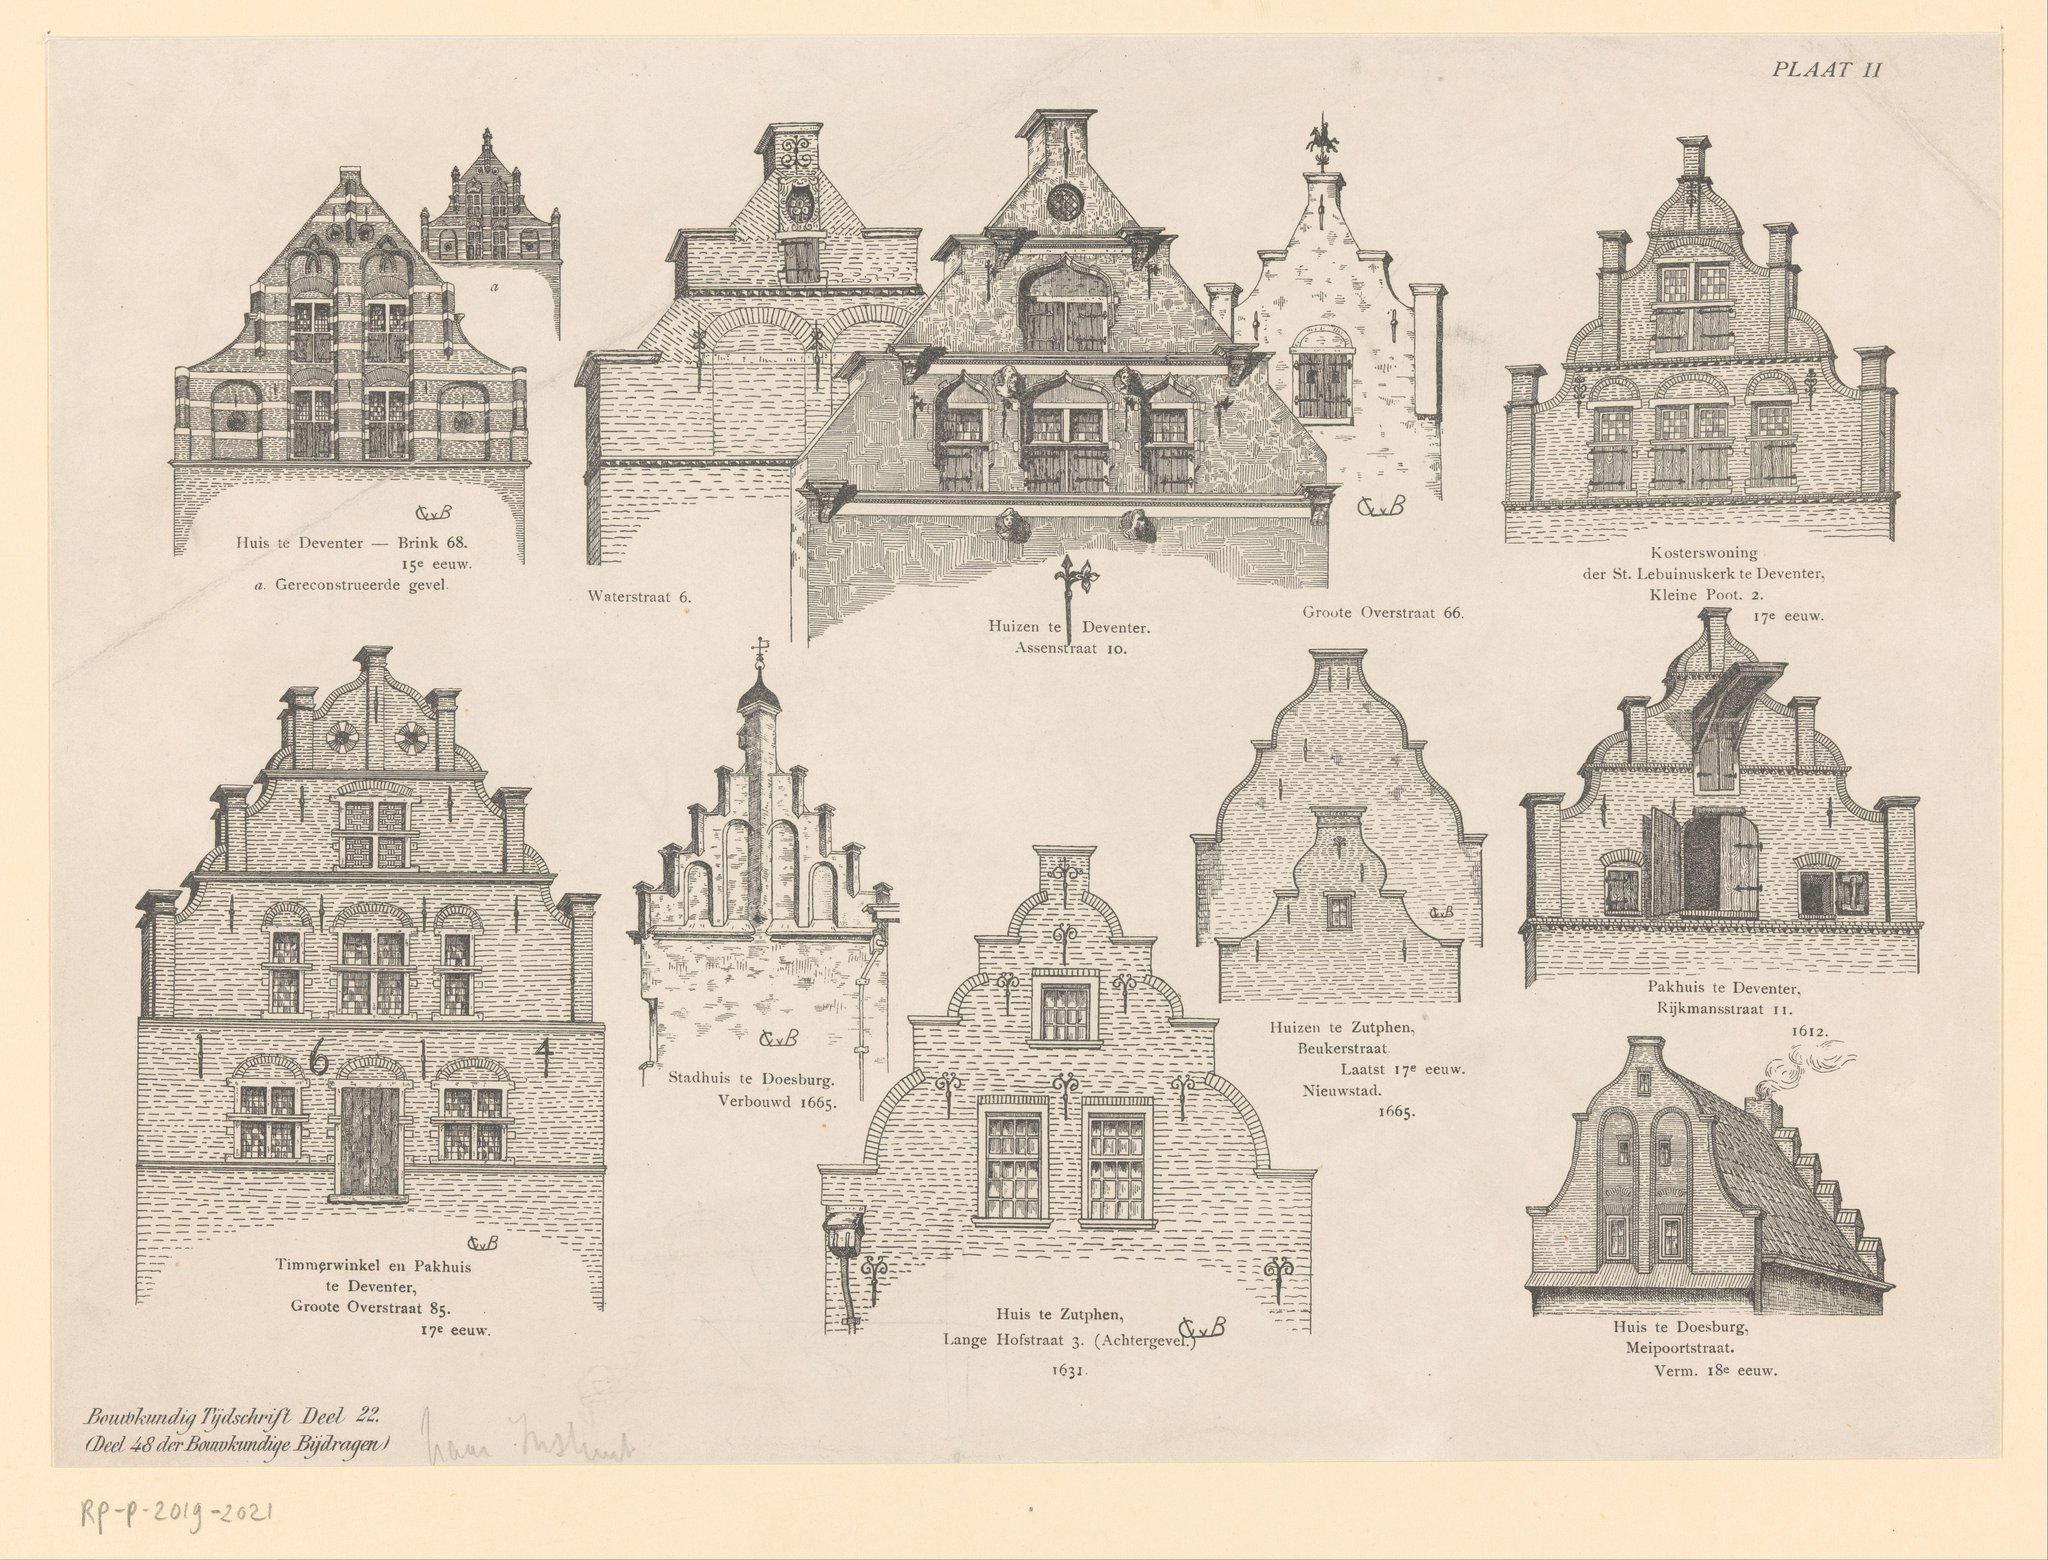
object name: reproduction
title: Reproductie van tekeningen met gevels van verschillende huizen in Deventer, Doesburg en Zutphen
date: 1904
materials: paper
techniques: photolithography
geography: the hague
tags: exterior ~ representation of a building, façade (of house or building), deventer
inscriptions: monogram: ‘CvB’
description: Rechtsboven: plaat II. Linksonder: Bouwkundig Tijdschrift Deel 22 (Deel 48 der Bouwkundige Bijdragen).